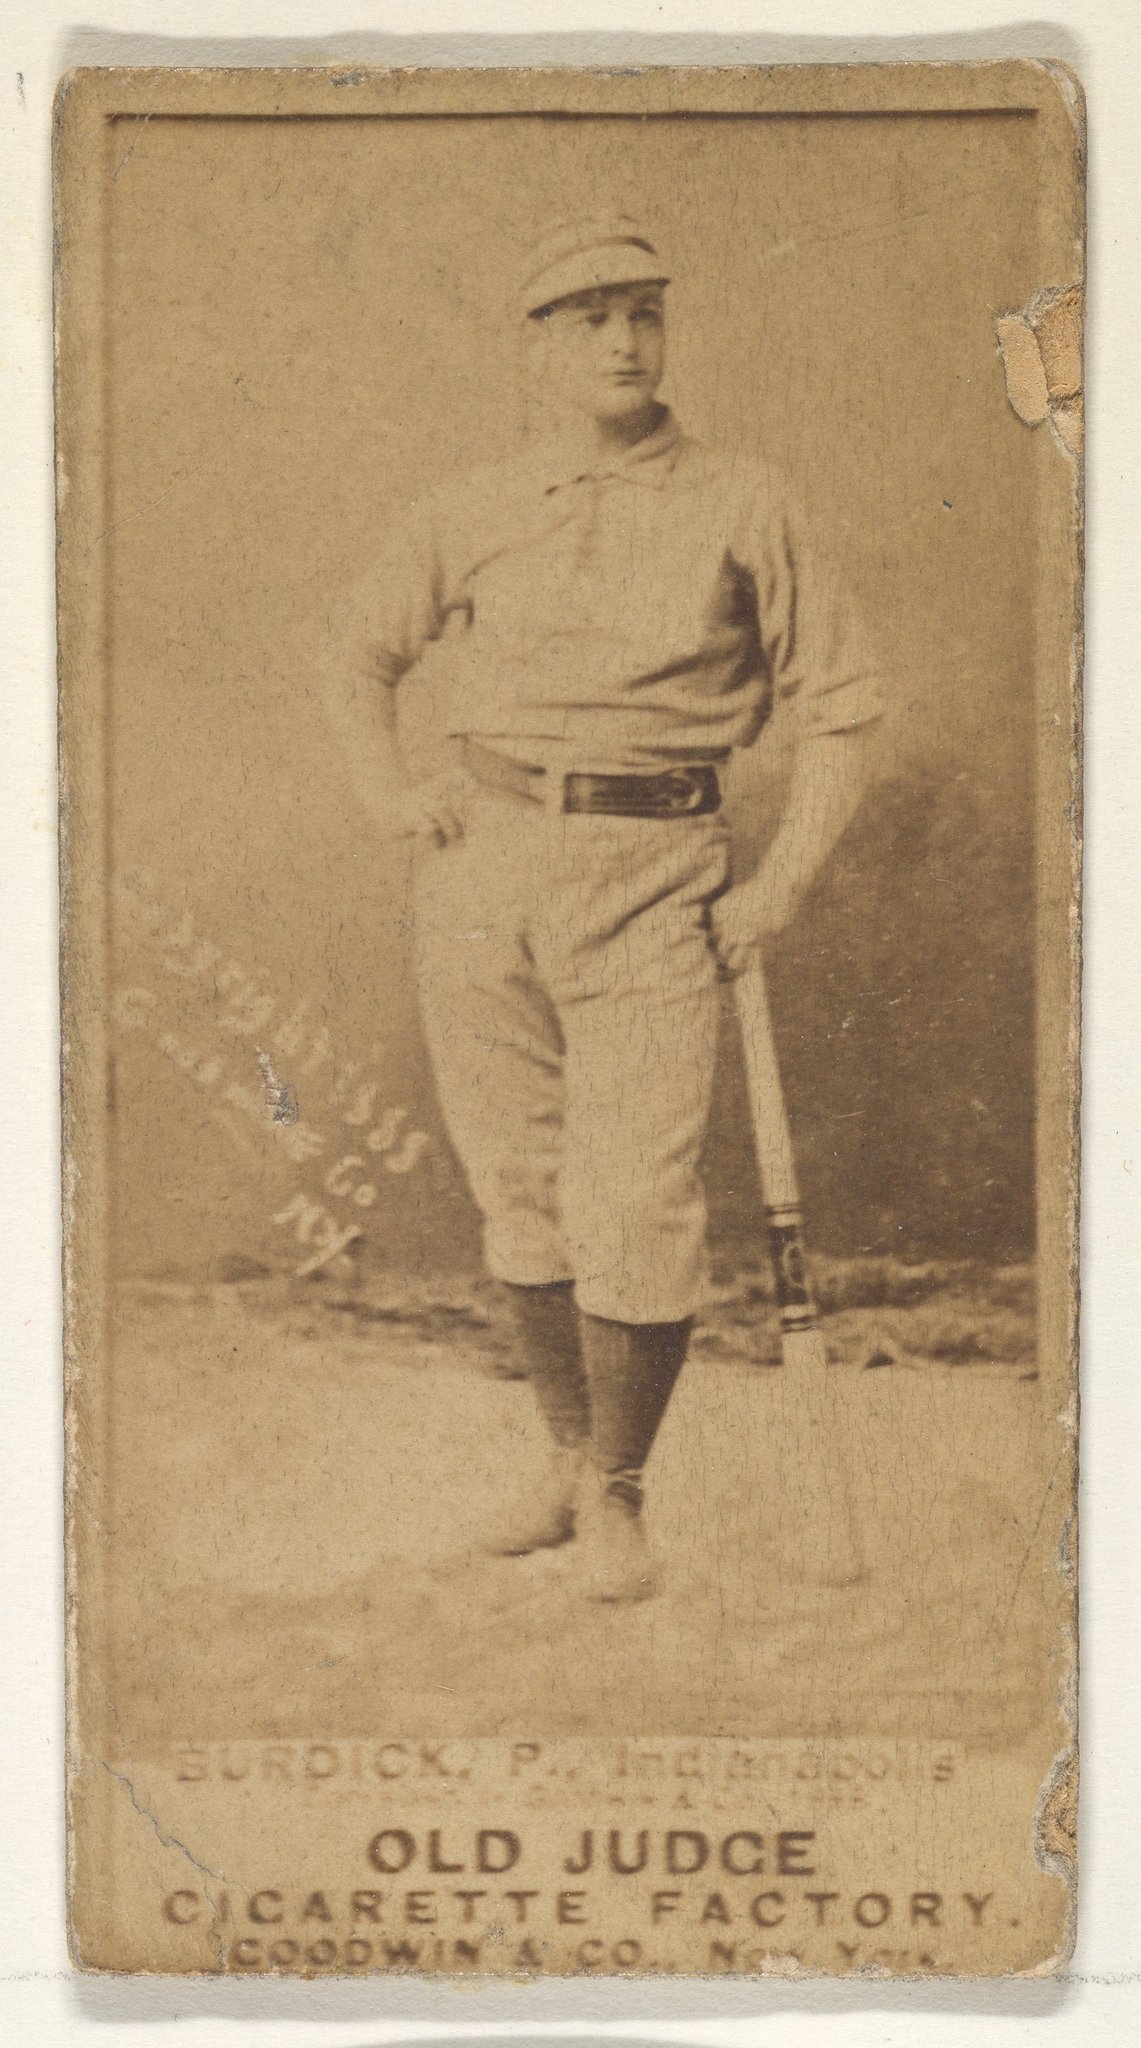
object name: baseball card, photograph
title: Burdick, Pitcher, Indianapolis, from the Old Judge series (N172) for Old Judge Cigarettes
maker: goodwin & company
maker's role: publisher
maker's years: 1850-1950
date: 1888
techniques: albumen silver print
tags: men,portraits,baseball,athletes